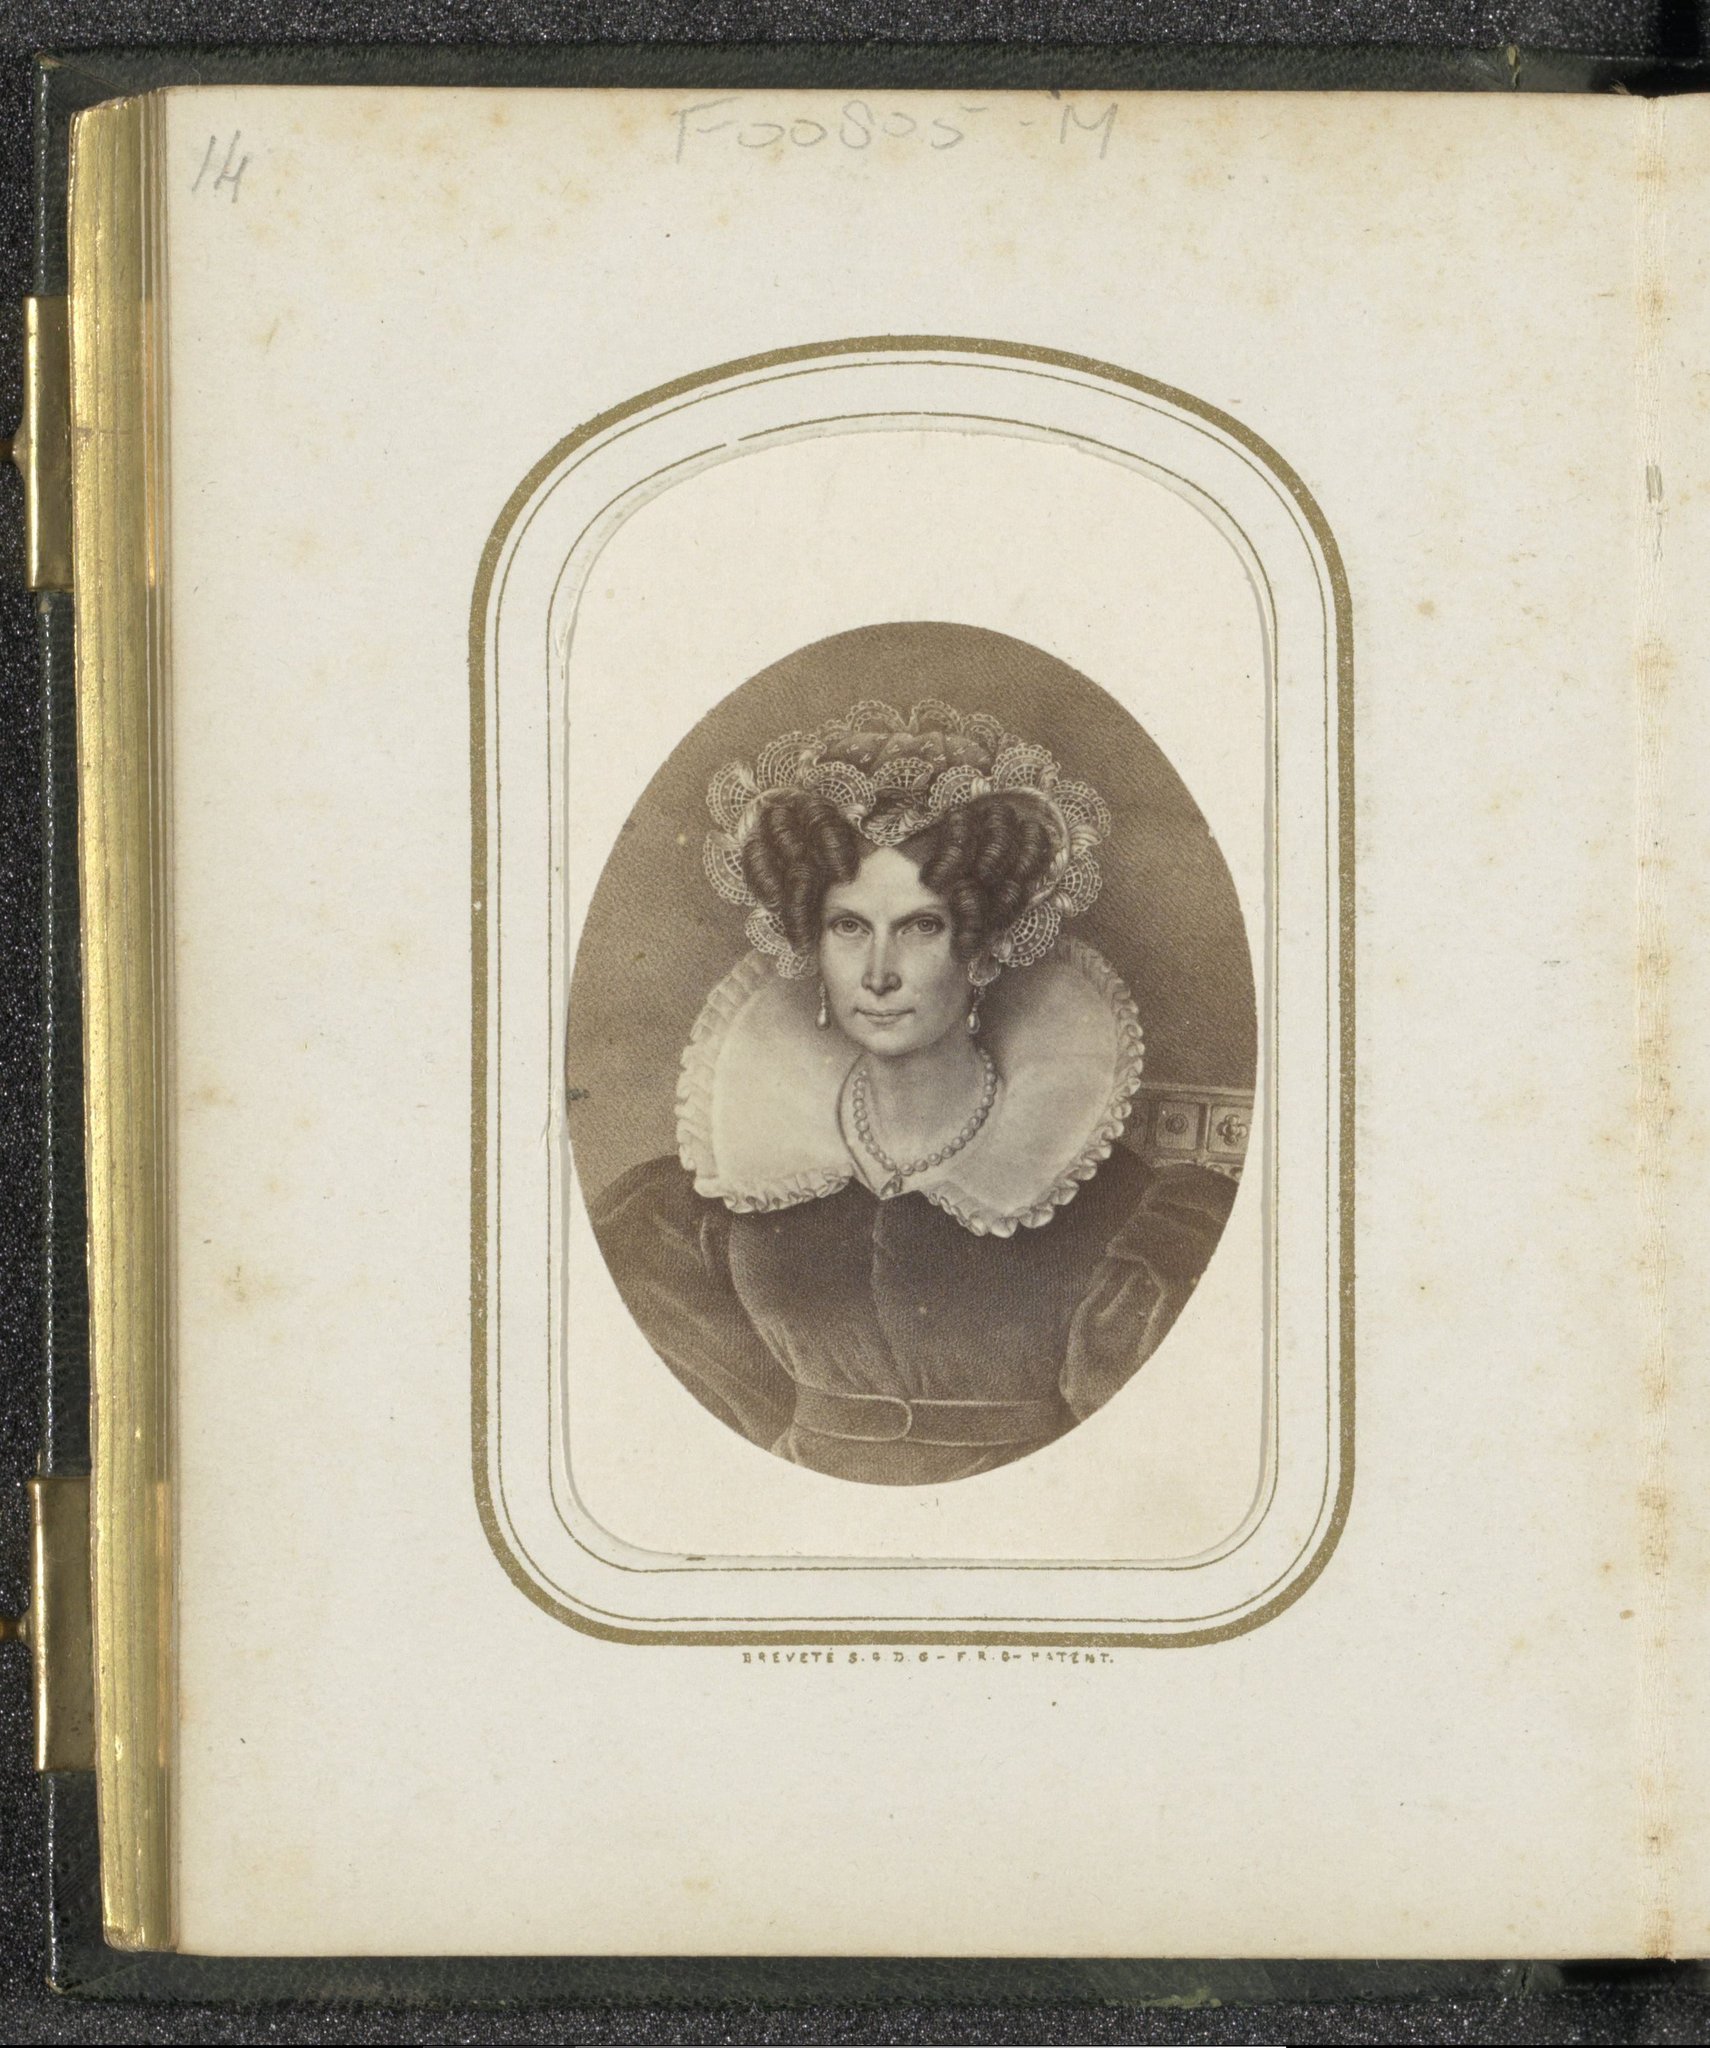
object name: reproduction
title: Fotoreproductie van (vermoedelijk) een prent van Wilhelmina van Pruisen, echtgenote van koning Willem I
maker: andries jager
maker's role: publisher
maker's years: 1825-1905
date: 1860-1880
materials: cardboard, paper, photographic support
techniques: albumen print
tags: berlin, wilhelmina frederica louisa (koningin der nederlanden), head-gear, historical persons, styles of hairdress - aa - ~ women, clothing for the upper part of the body, ruler, sovereign, neck-gear: collar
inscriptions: address: ‘Water 110 Amsterdam’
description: Onderdeel van Fotoalbum met 29 foto's van Nederlandse vorsten.